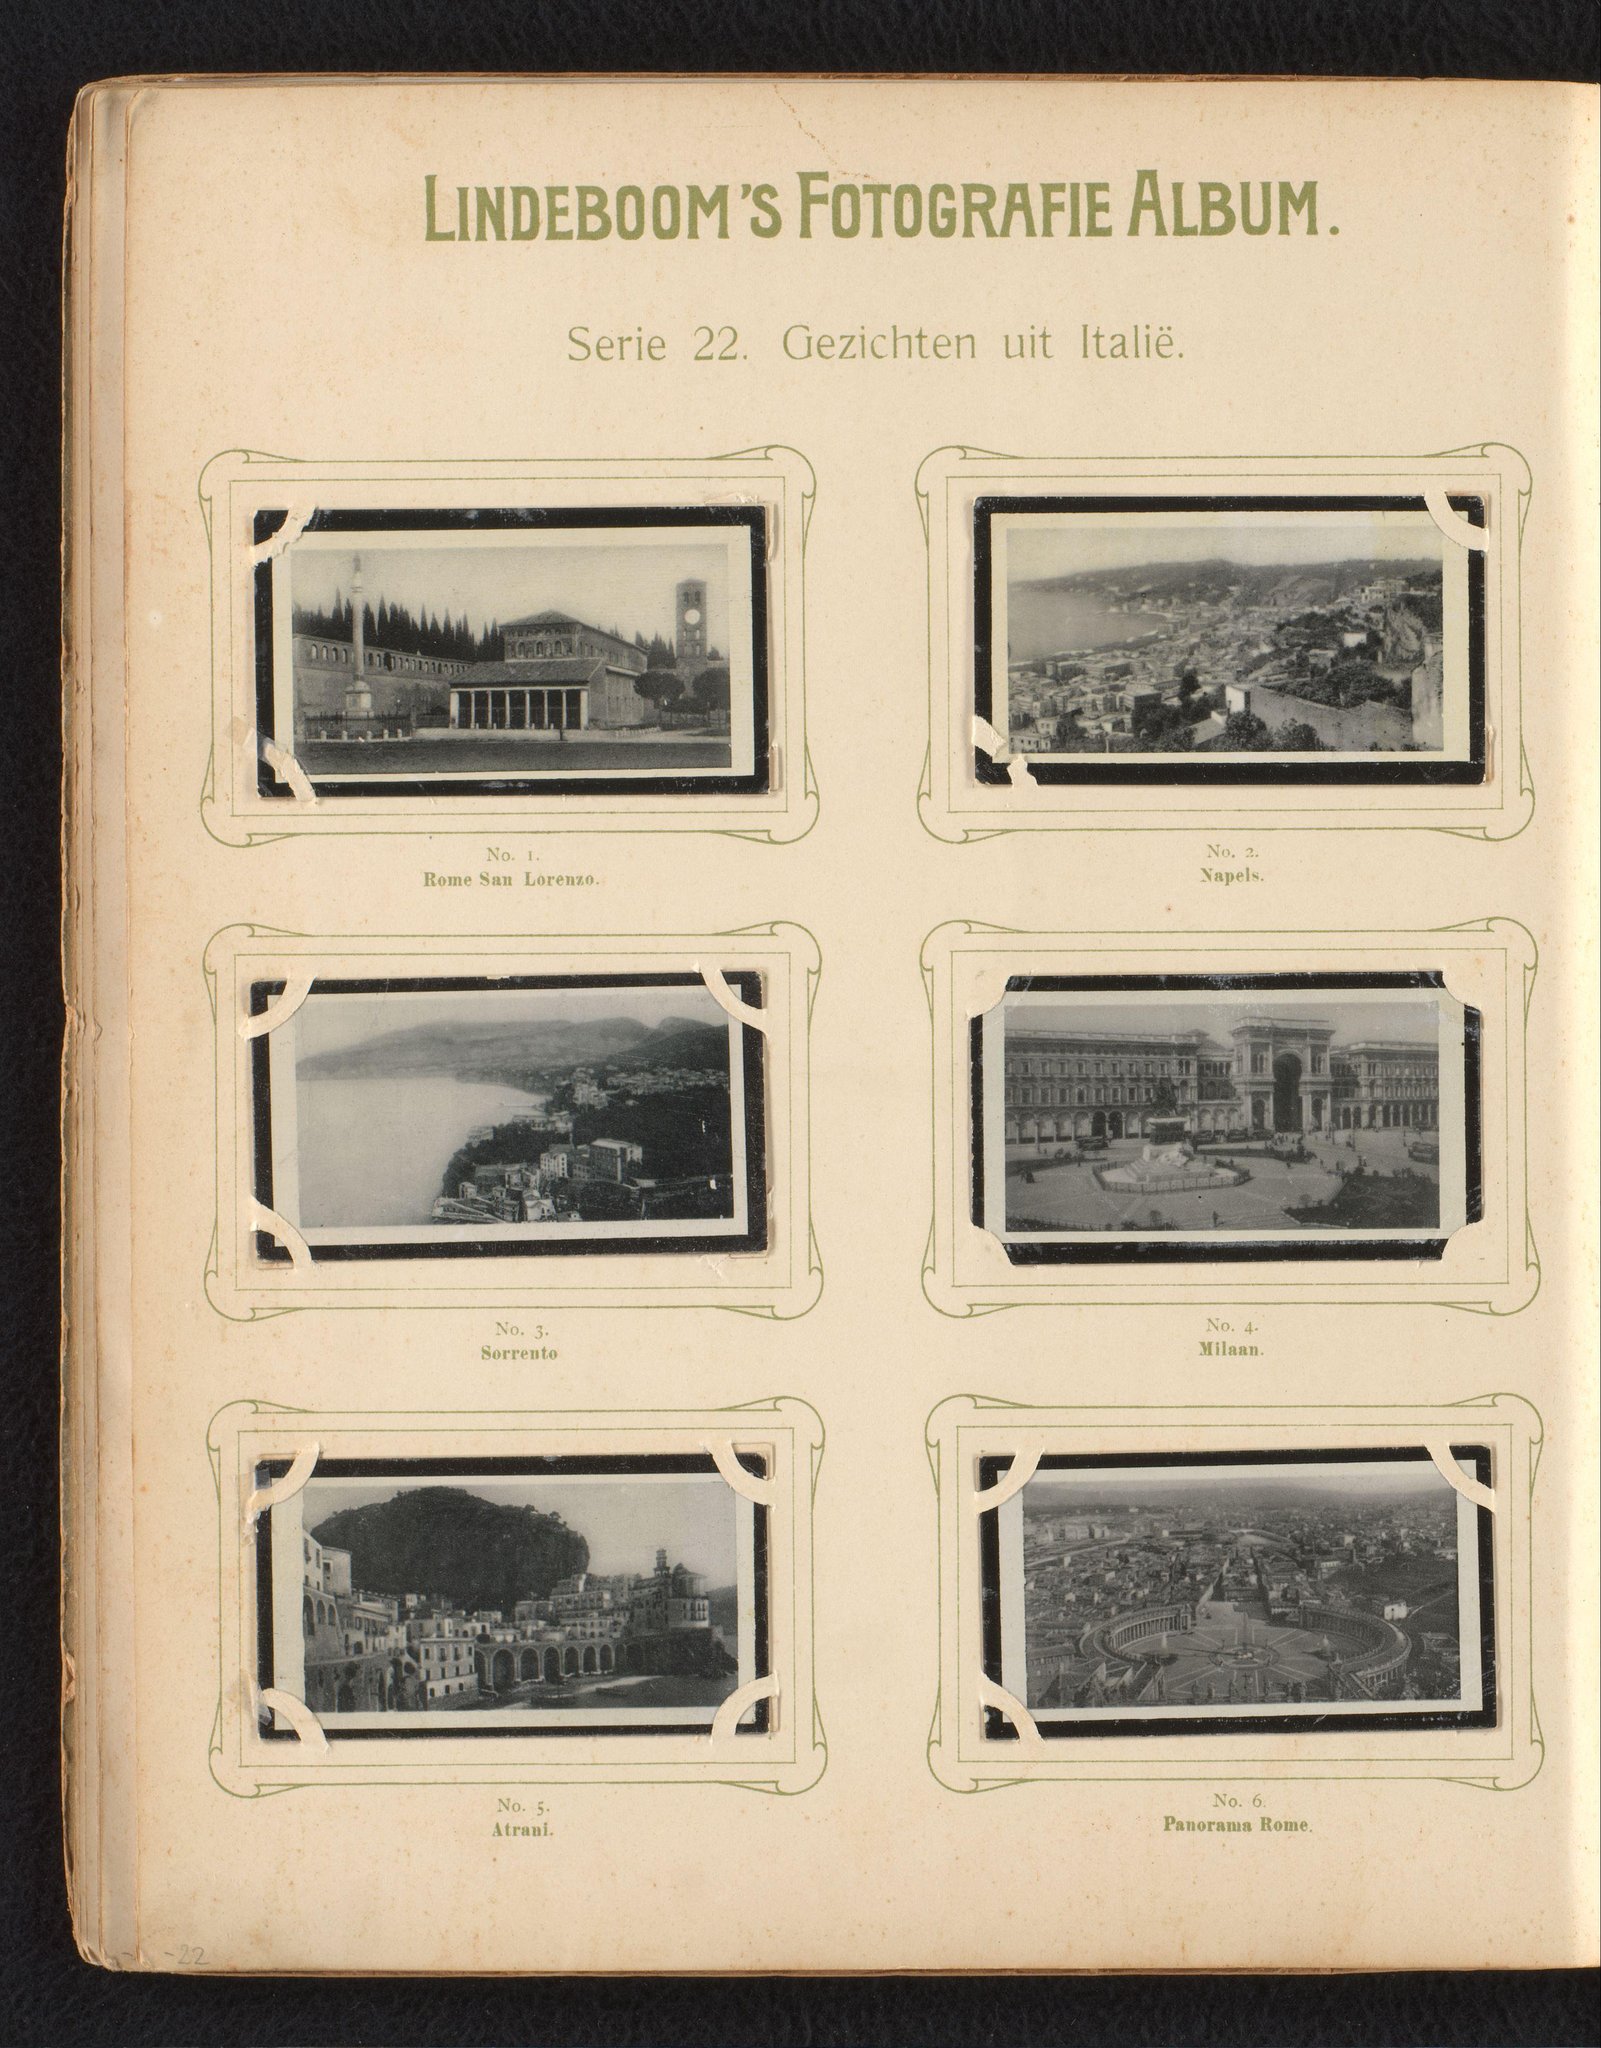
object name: reproduction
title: Gezichten uit Italië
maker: Anonymous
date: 1905-1906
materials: cardboard, paper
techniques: photograph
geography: amsterdam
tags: city-view in general; 'veduta', naples, rome, sorrento, atrani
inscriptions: inscription: ‘Serie 22.’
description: Dergelijke prenten stonden bekend als 'zwartjes'. Men verkreeg ze bij aanschaf van bepaalde merken thee, cacao, sigaretten, beschuit, etc. om te verzamelen. Er waren speciaal voor de 'zwartjes' vervaardigde verzamelalbums in omloop.